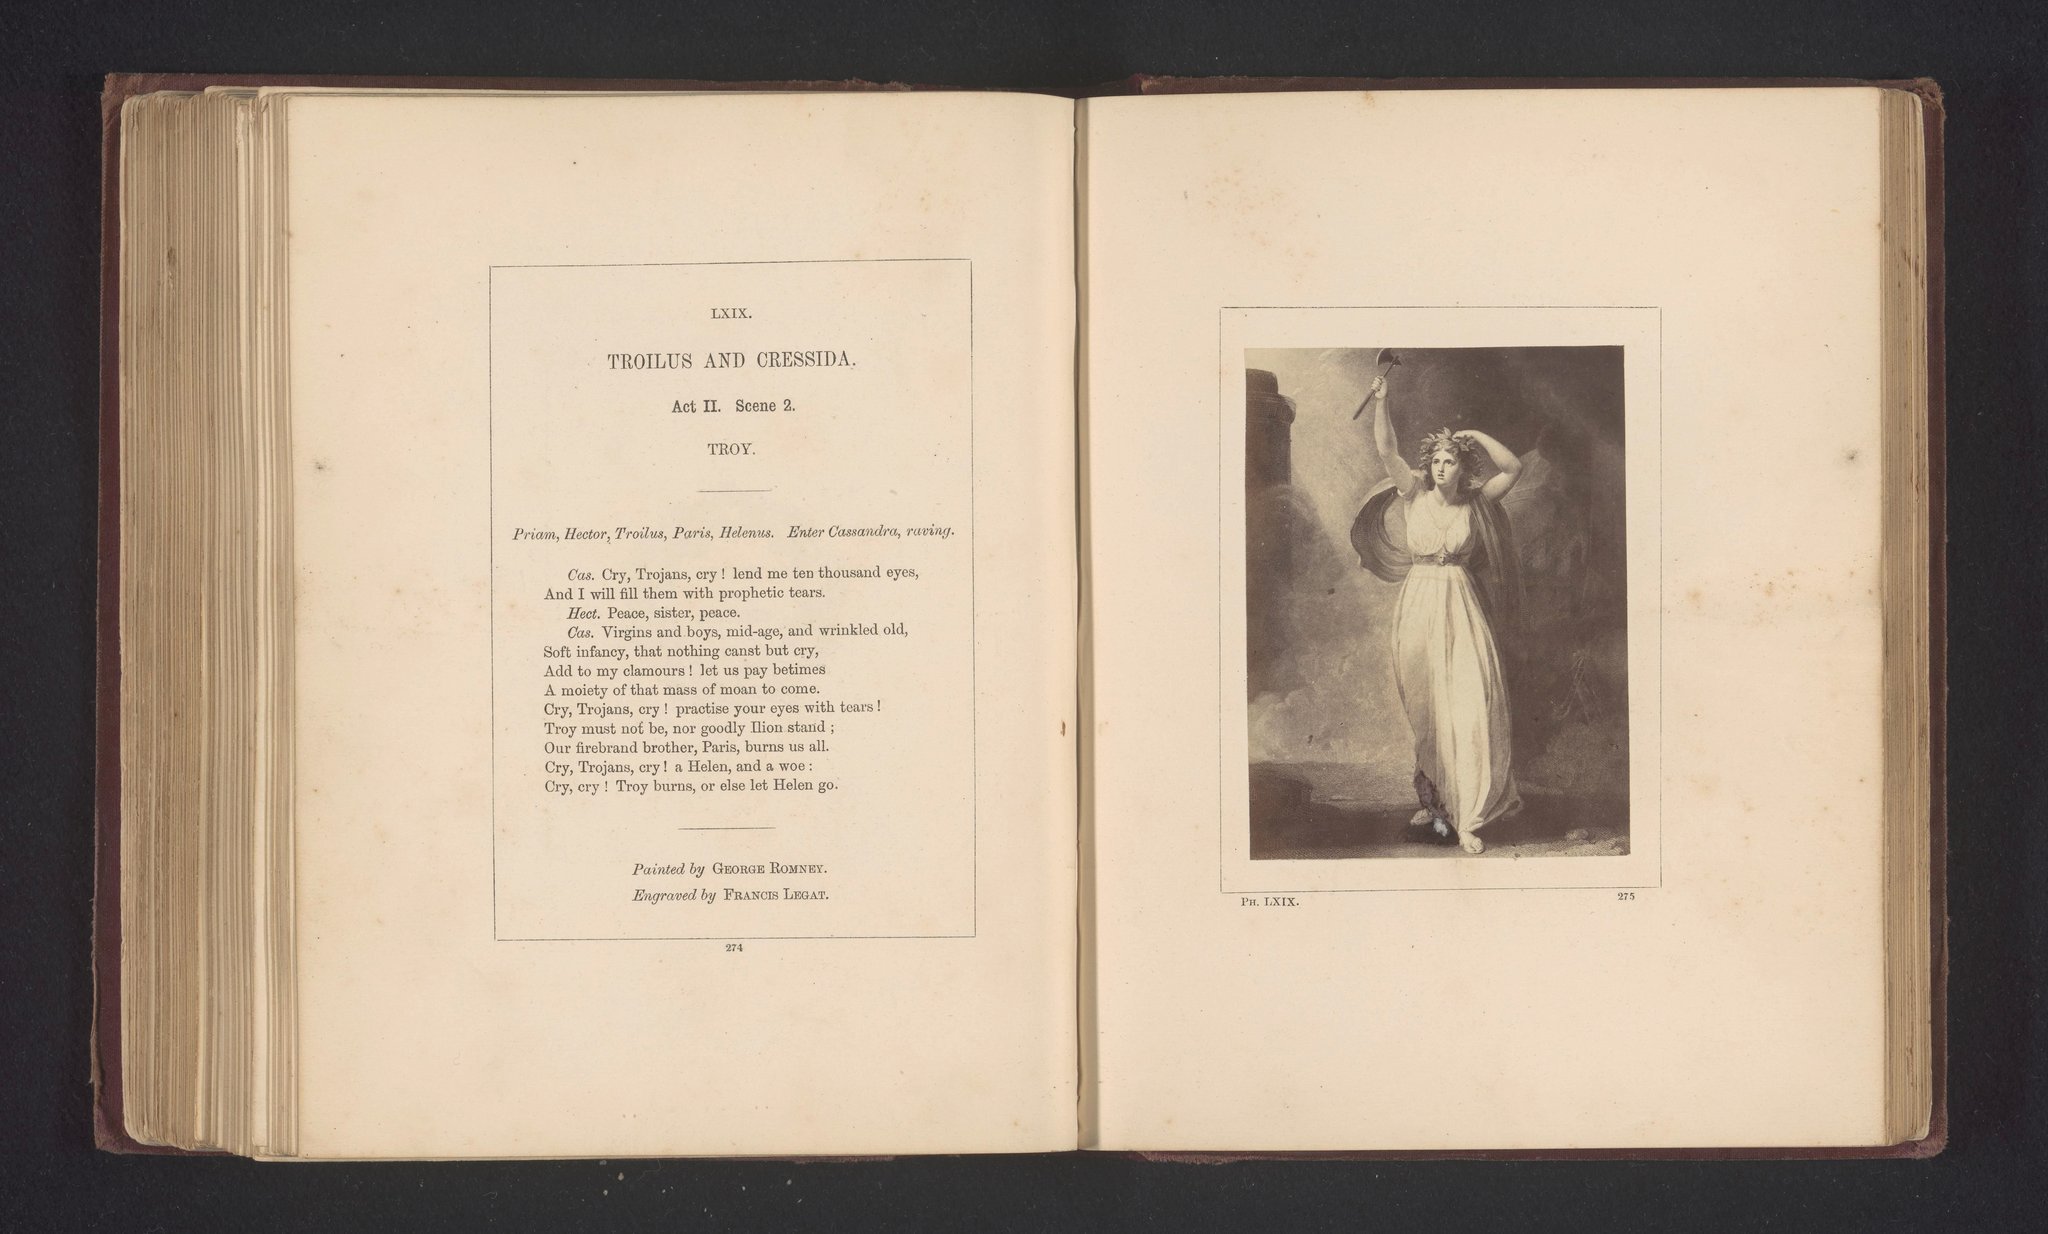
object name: page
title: Fotoreproductie van een prent naar een schilderij door George Romney, voorstellend een scene uit Troilus en Cressida door William Shakespeare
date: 1854-1867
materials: photographic support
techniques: albumen print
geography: london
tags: specific works of literature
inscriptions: number: ‘Ph. LXIX. 275’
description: Te zien is akte II, scene 2 met Cassandra die ijlend verschijnt.